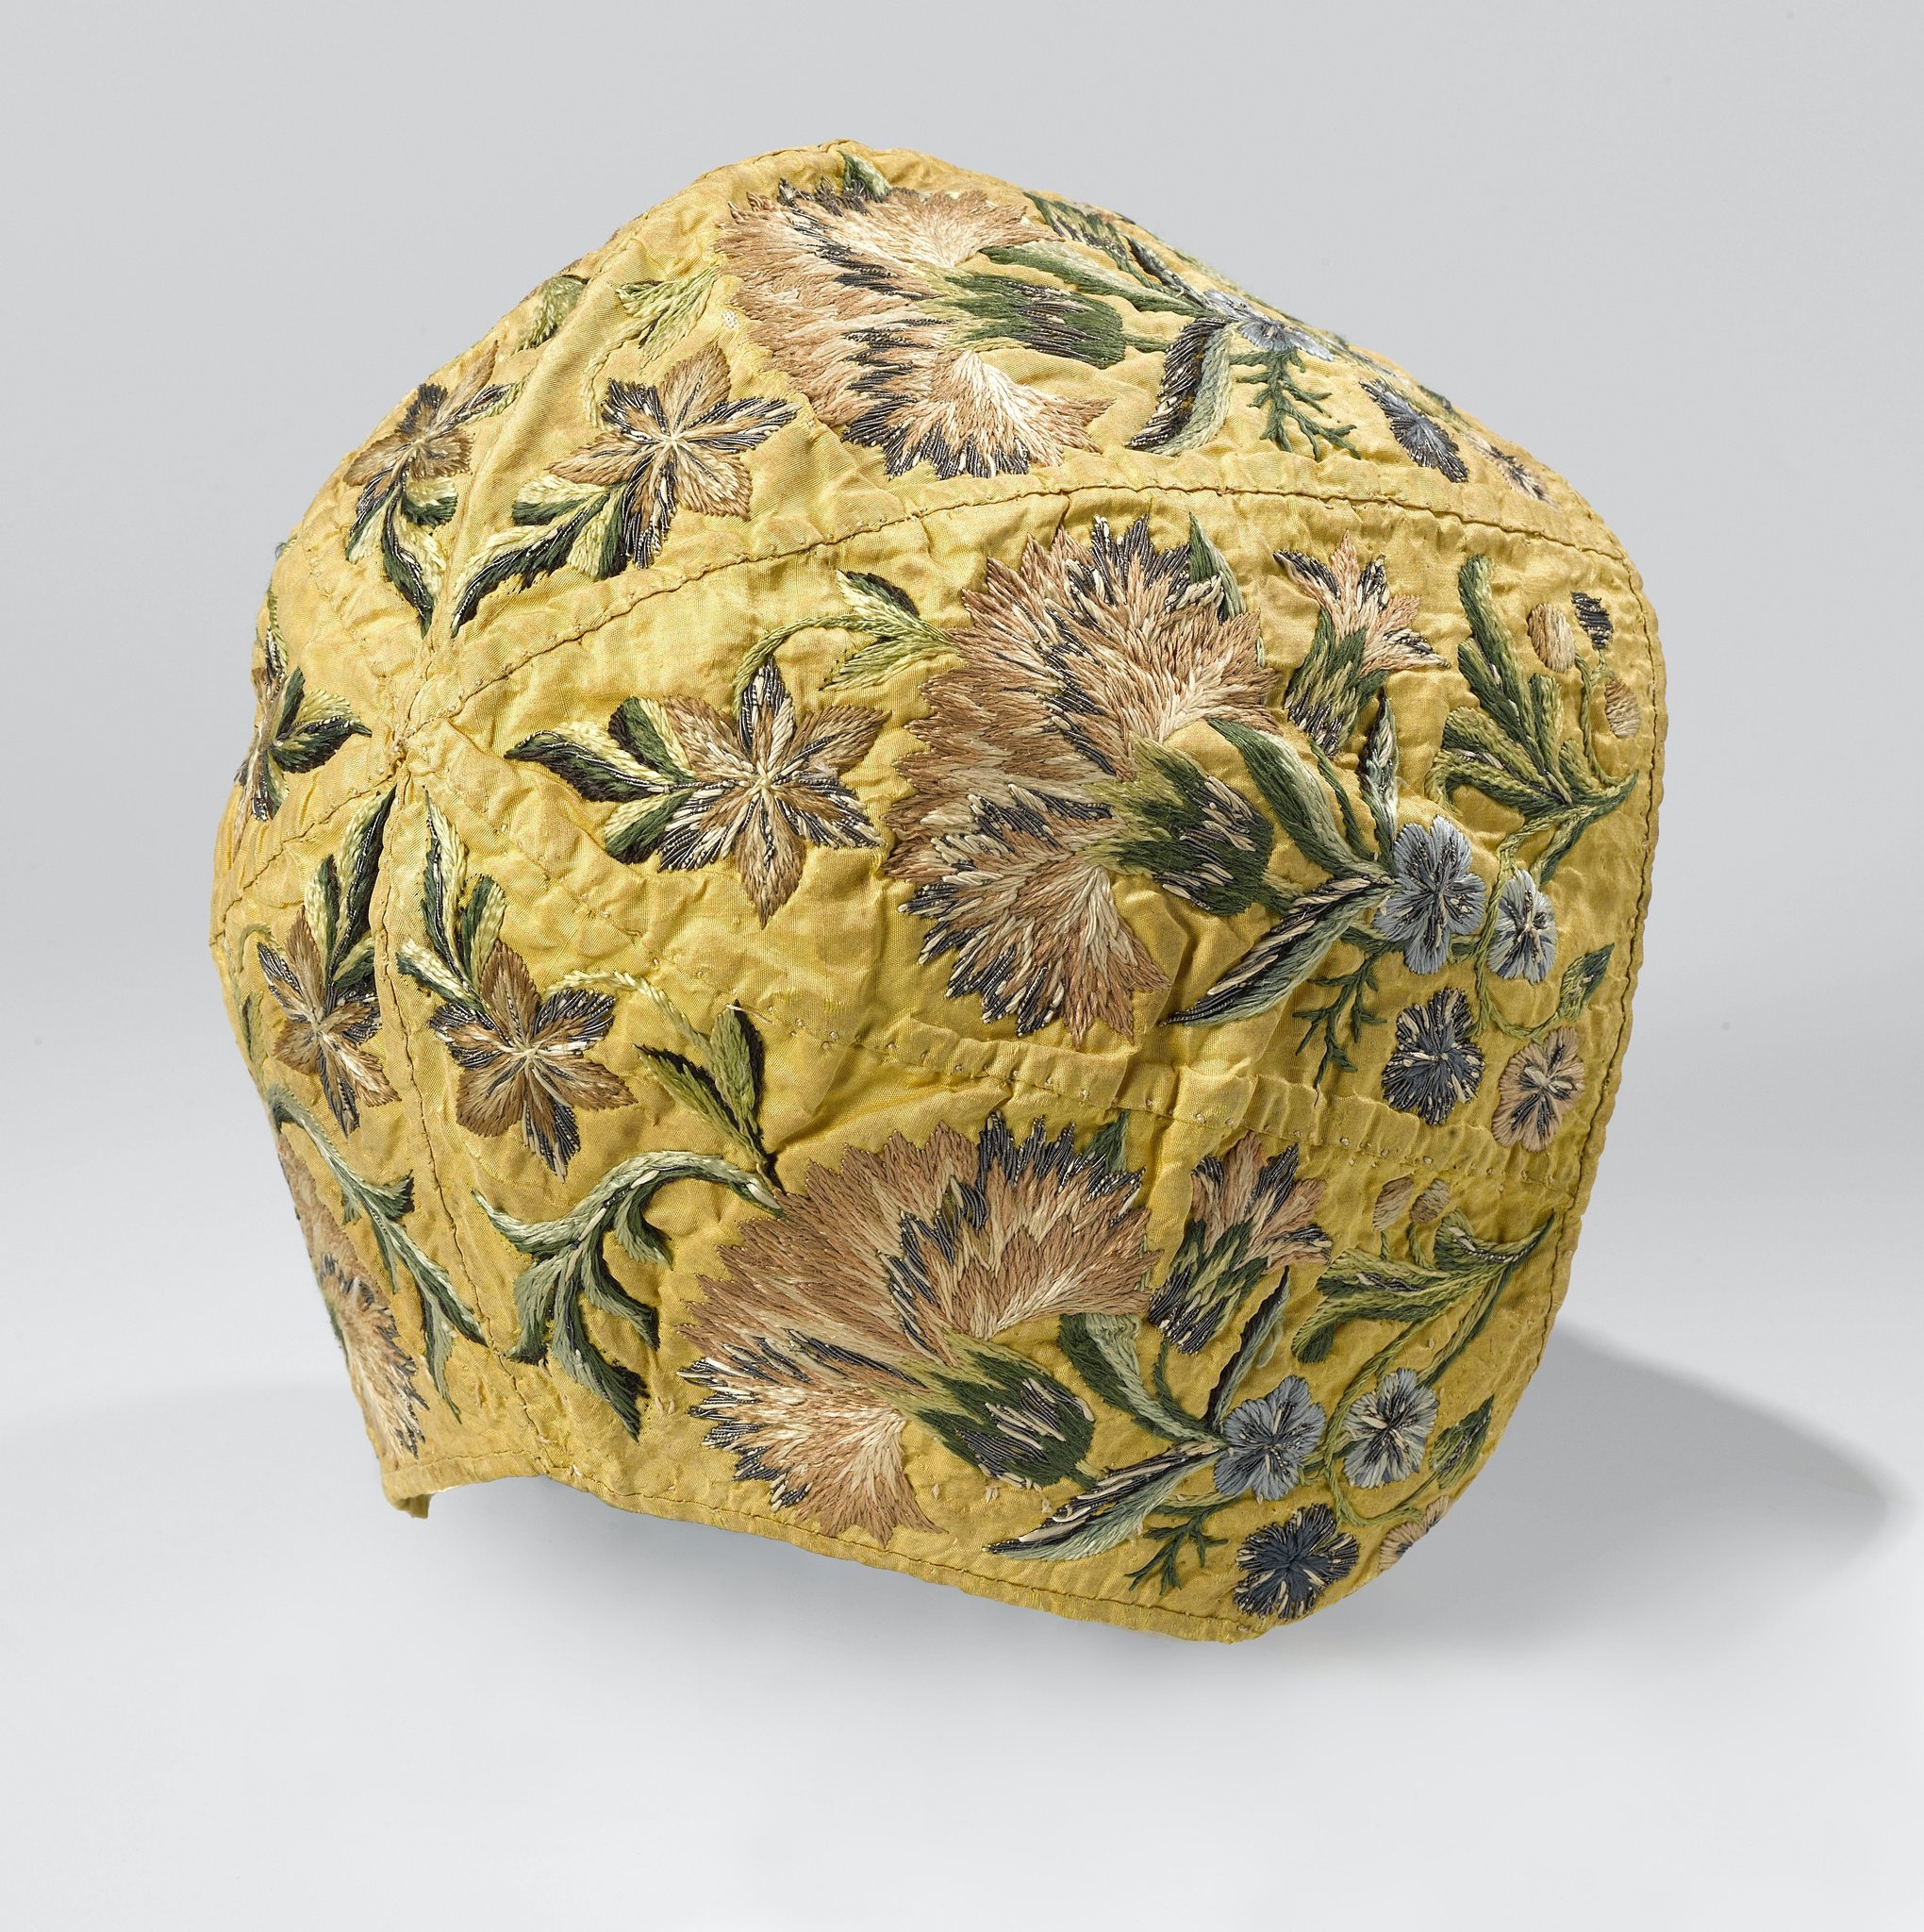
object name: womenswear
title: Muts van gele zijde bestaande uit zes gelijke pattes, geborduurd met floraal patroon in veelkleurige zijde en zilverdraad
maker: Anonymous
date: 1750-1775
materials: linen, silk, thread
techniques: embroidered, weave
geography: netherlands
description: Muts van gele zijde bestaande uit zes gelijke pattes, geborduurd met floraal patroon in veelkleurige zijde en zilverdraad. Model: samengesteld uit zes gelijke pattes van gele zijde met naturel linnen voering. De linnen voering (mogelijk ter versteviging gebruikt) is meegeborduurd, waardoor de afwerking aan de binnenkant te zien is. De punten aan weerskanten van het gezicht zijn naar binnen geslagen en vastgezet. Versiering: geborduurd in veelkleurige zijde en zilverdraad met op iedere patte een anjer omgeven door viooltjes en vergeet-me-nietjes in ingrijpsteek.